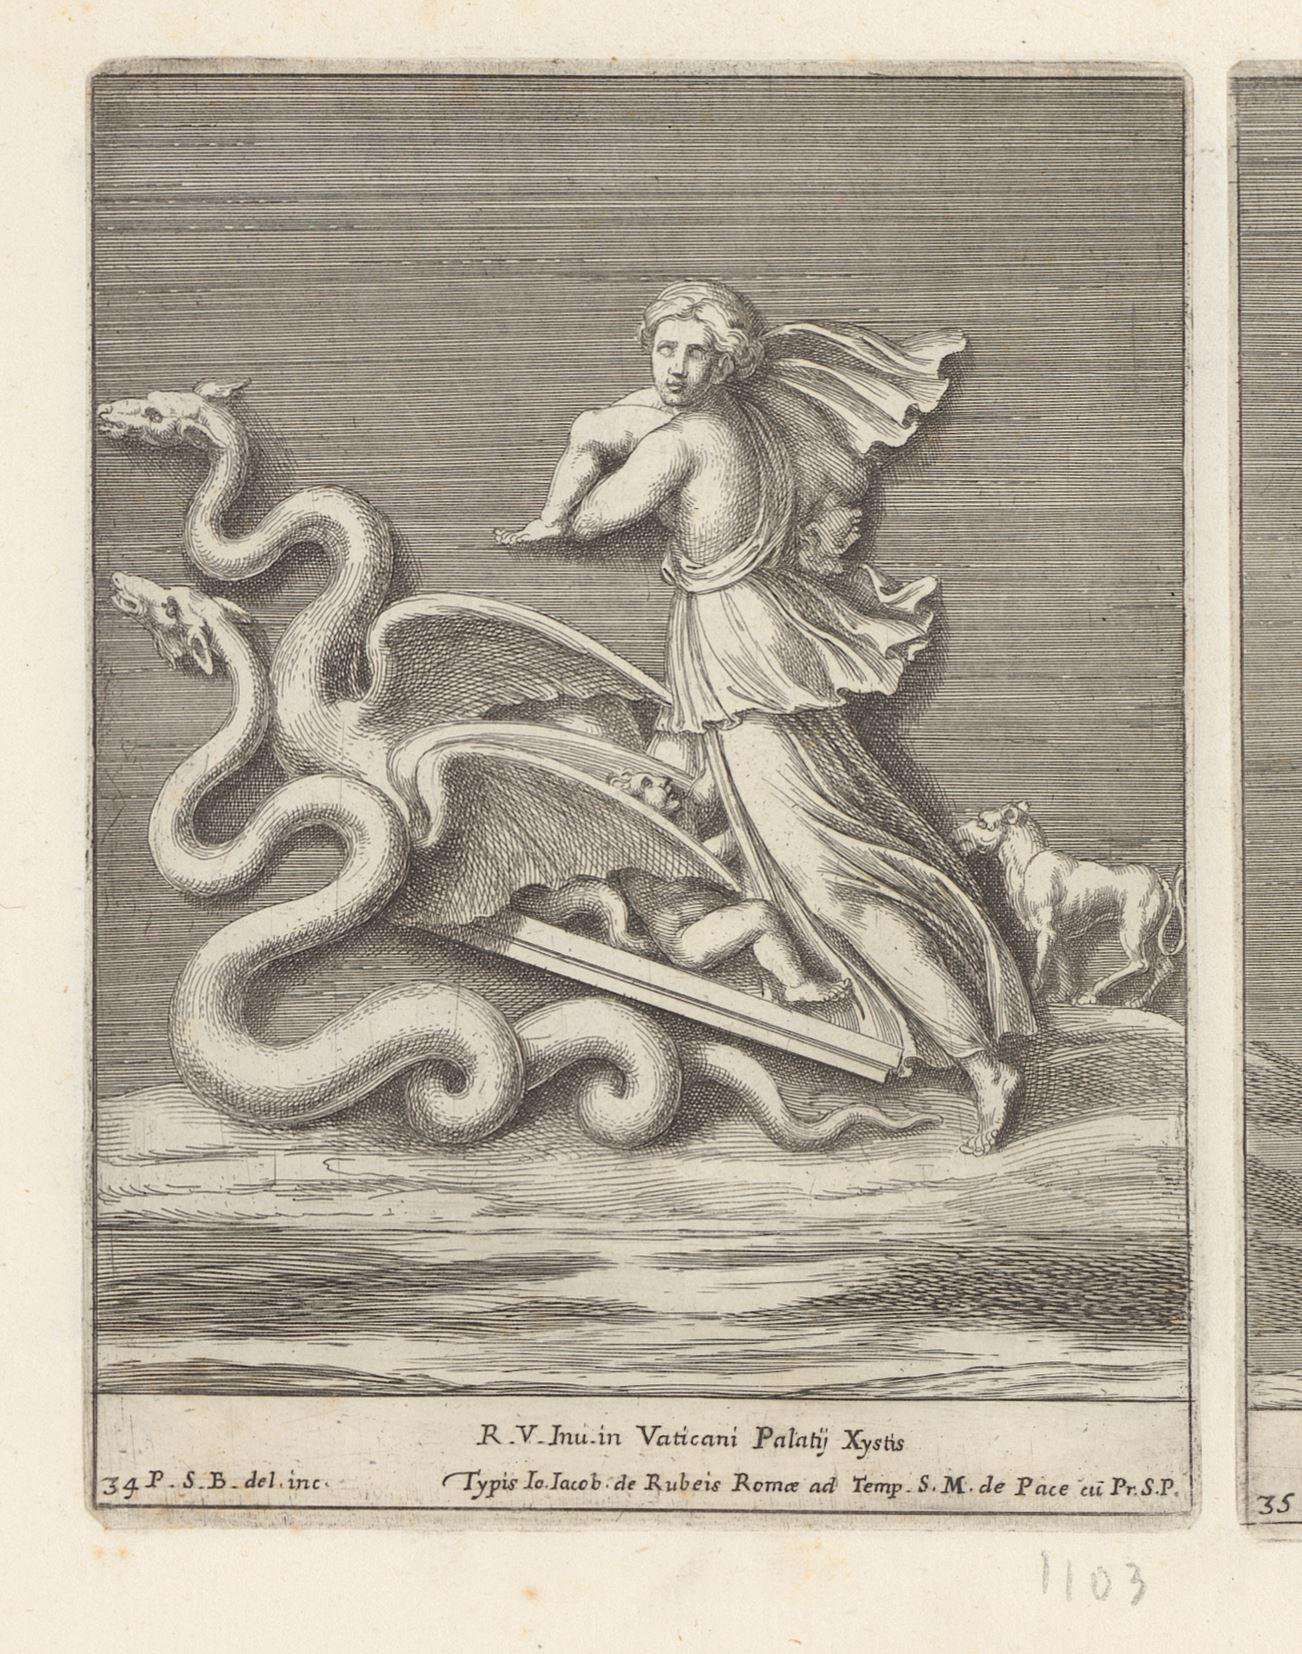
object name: print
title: Reliëfs in de Loggia van Rafaël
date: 1645-1700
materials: paper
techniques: engraving, etching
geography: vatican city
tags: medea kills her two children; she flees from corinth in a chariot drawn by winged dragons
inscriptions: number: ‘16’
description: Prent uit een reeks naar de gipsen reliëfs door Rafaël en uitgevoerd door zijn assistenten in de Vaticaanse Loggia.